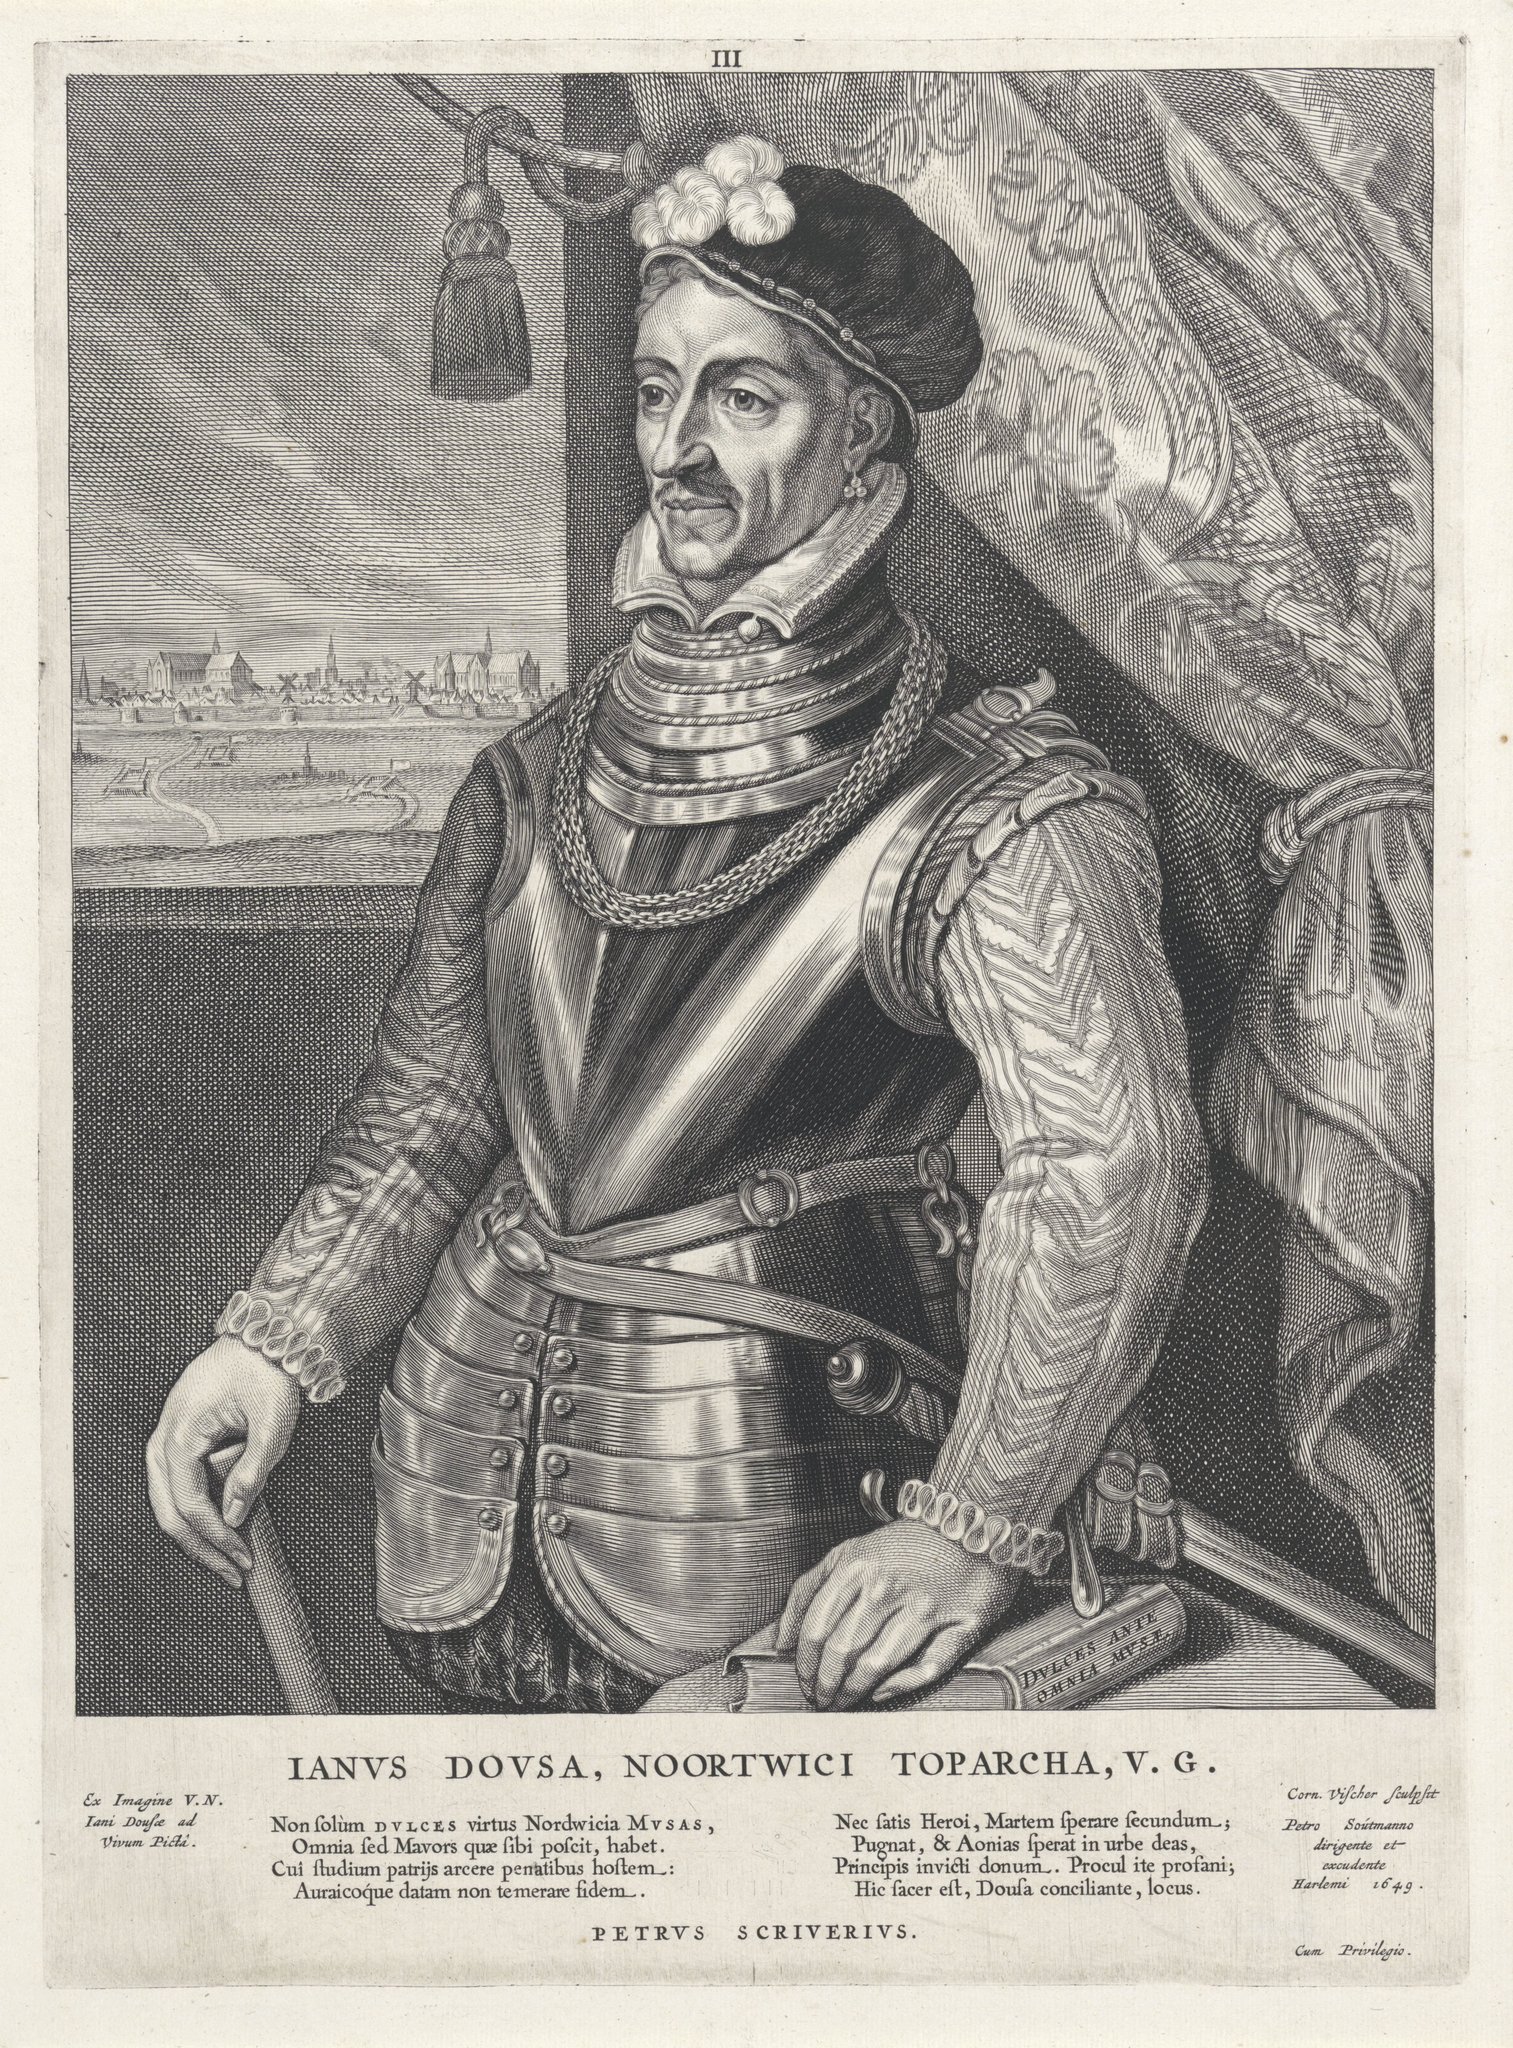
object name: print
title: Portret van Johan van der Does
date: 1649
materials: paper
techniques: engraving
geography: haarlem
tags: ear-rings (+ men's clothes), armour, necklace (+ men's clothes), leiden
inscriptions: collector's mark: Lugt 240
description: Johan van der Does, heer van Noordwijk en commandant van de vrijwillige troepen in de stad tijdens het beleg van Leiden in 1574. Op de achtergrond weilanden en de contouren van Leiden. Prent uit een serie van 5 prenten met portretten van belangrijke figuren tijdens het Beleg van Leiden.